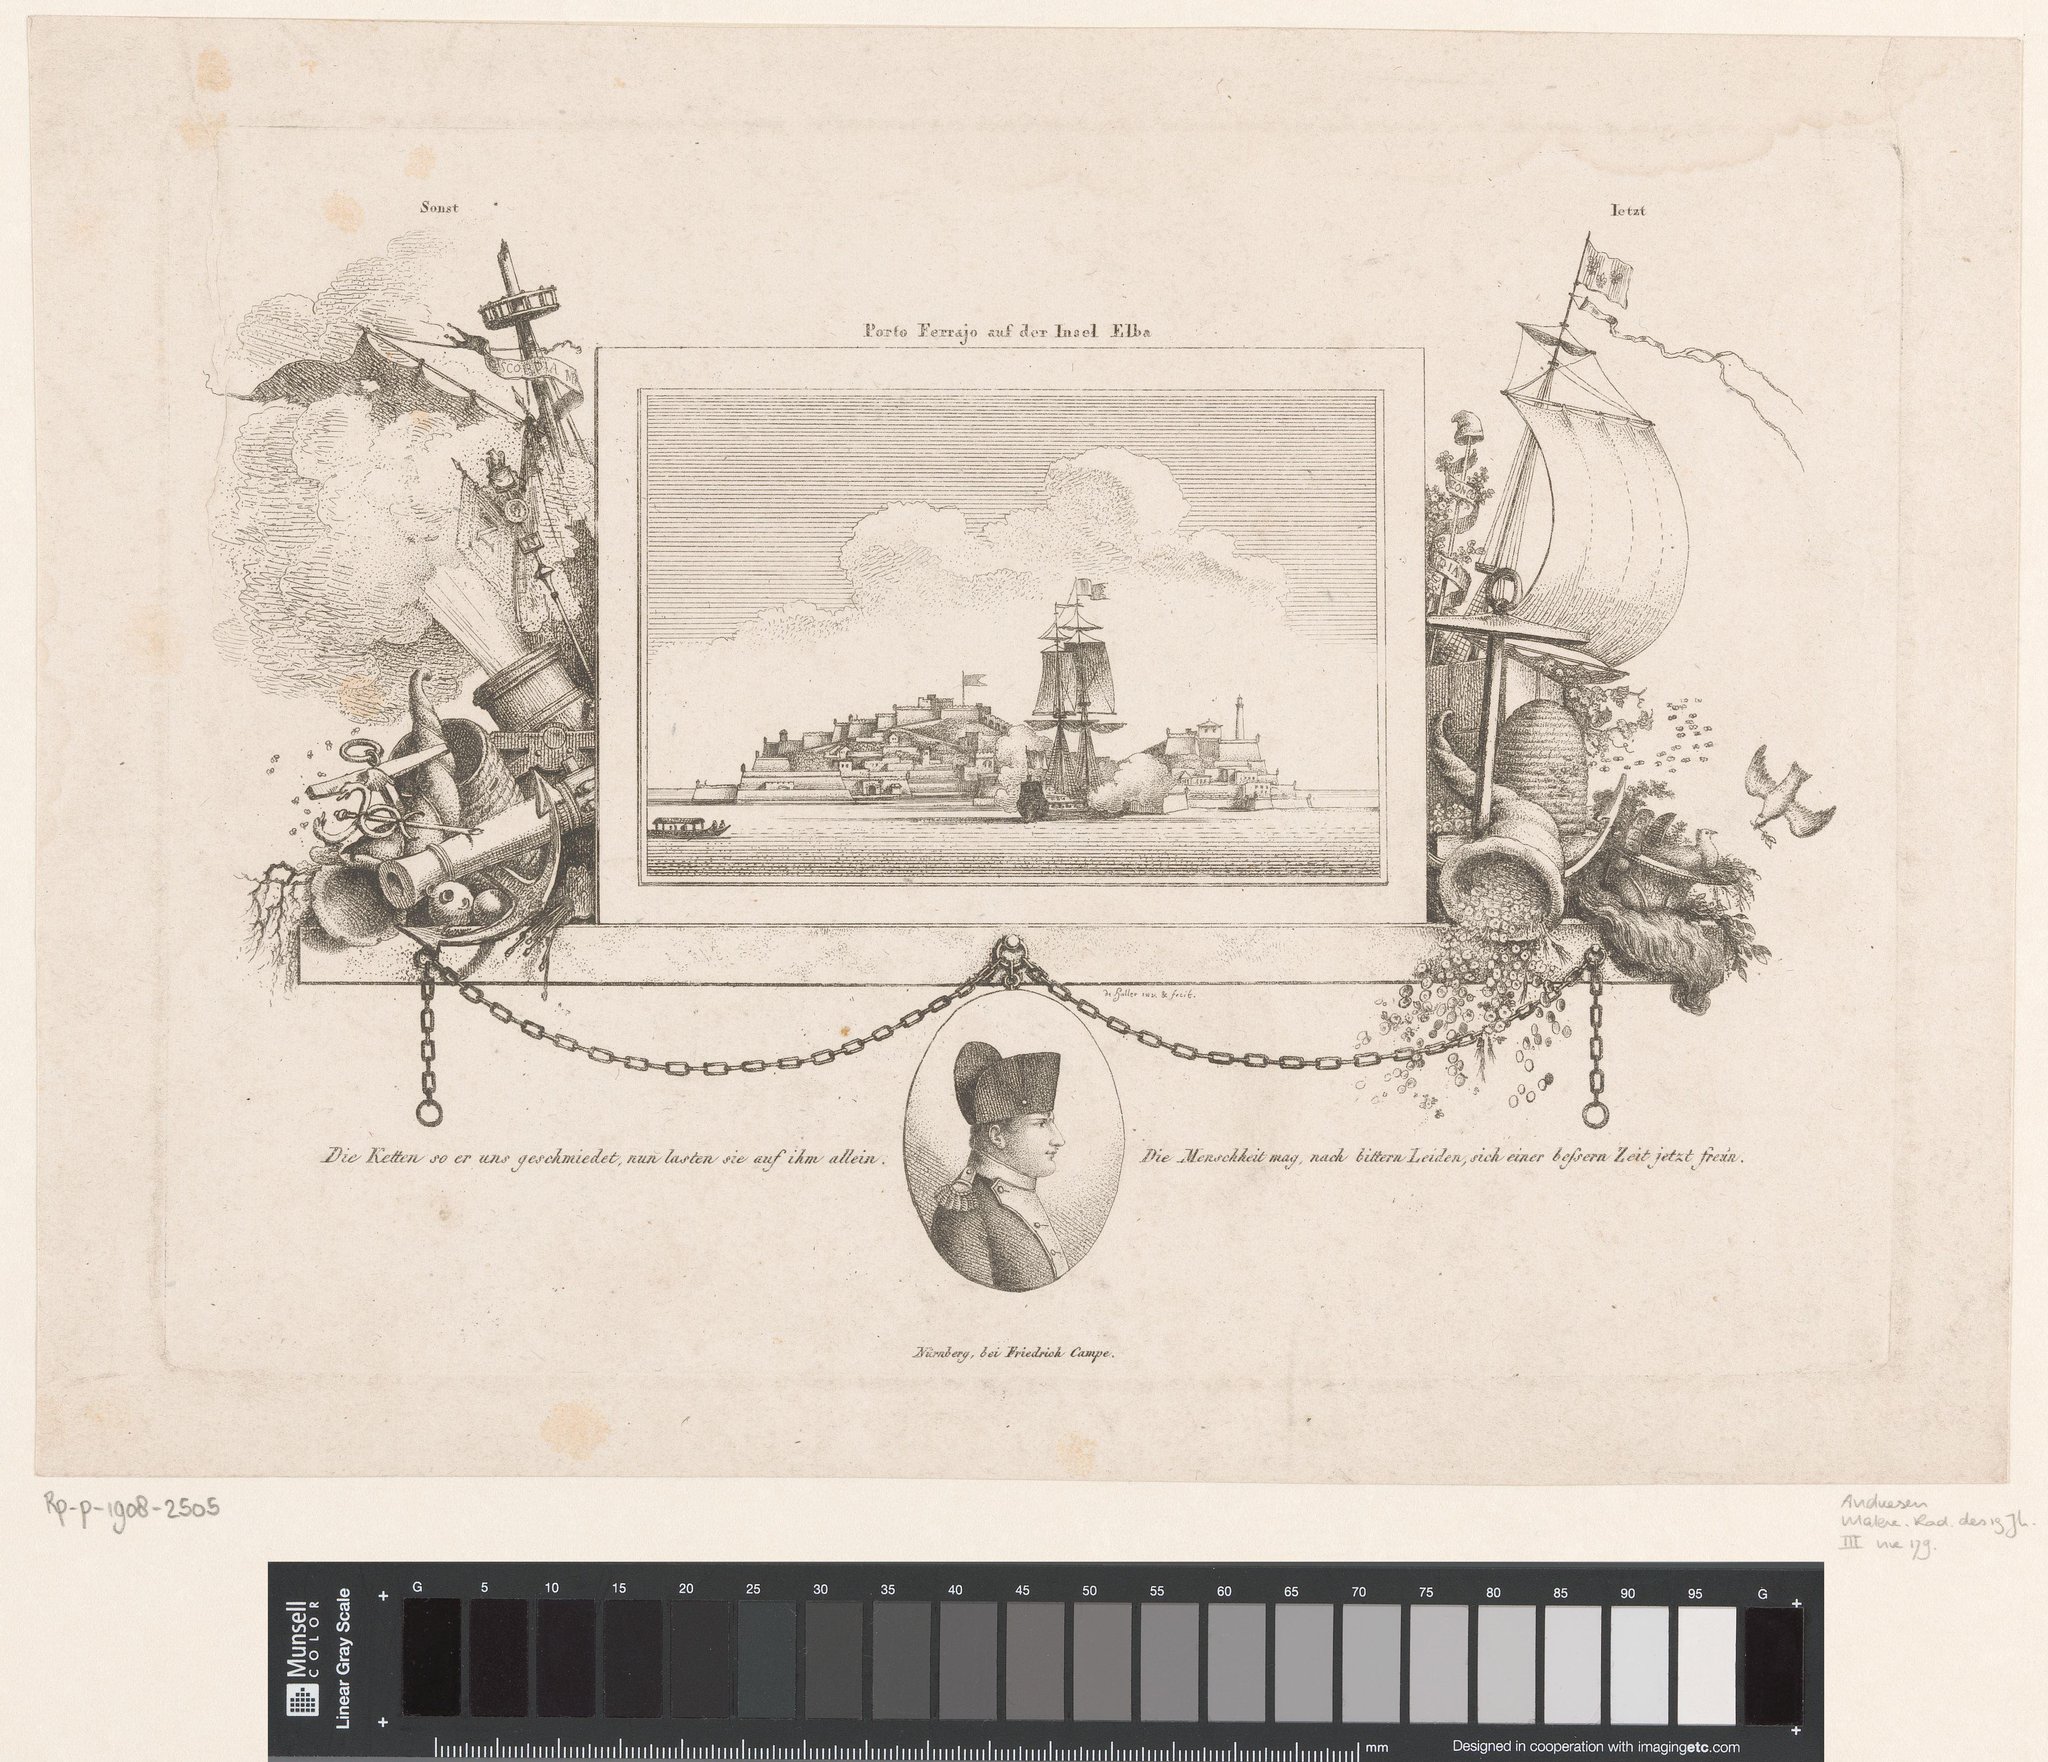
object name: print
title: Porto Ferrajo auf der Insel Elba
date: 1801-1821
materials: paper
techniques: etching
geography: nuremberg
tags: napoleon i (emperor of the french), island, ornament ~ medallion, historical persons, navy, siege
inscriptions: collector's mark: Lugt 2228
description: Links naast het kader een allegorie op het verleden (sonst) van de zeevaart, rechts een allegorie op het heden (Ietzt). Met onderschrift in het Duits.